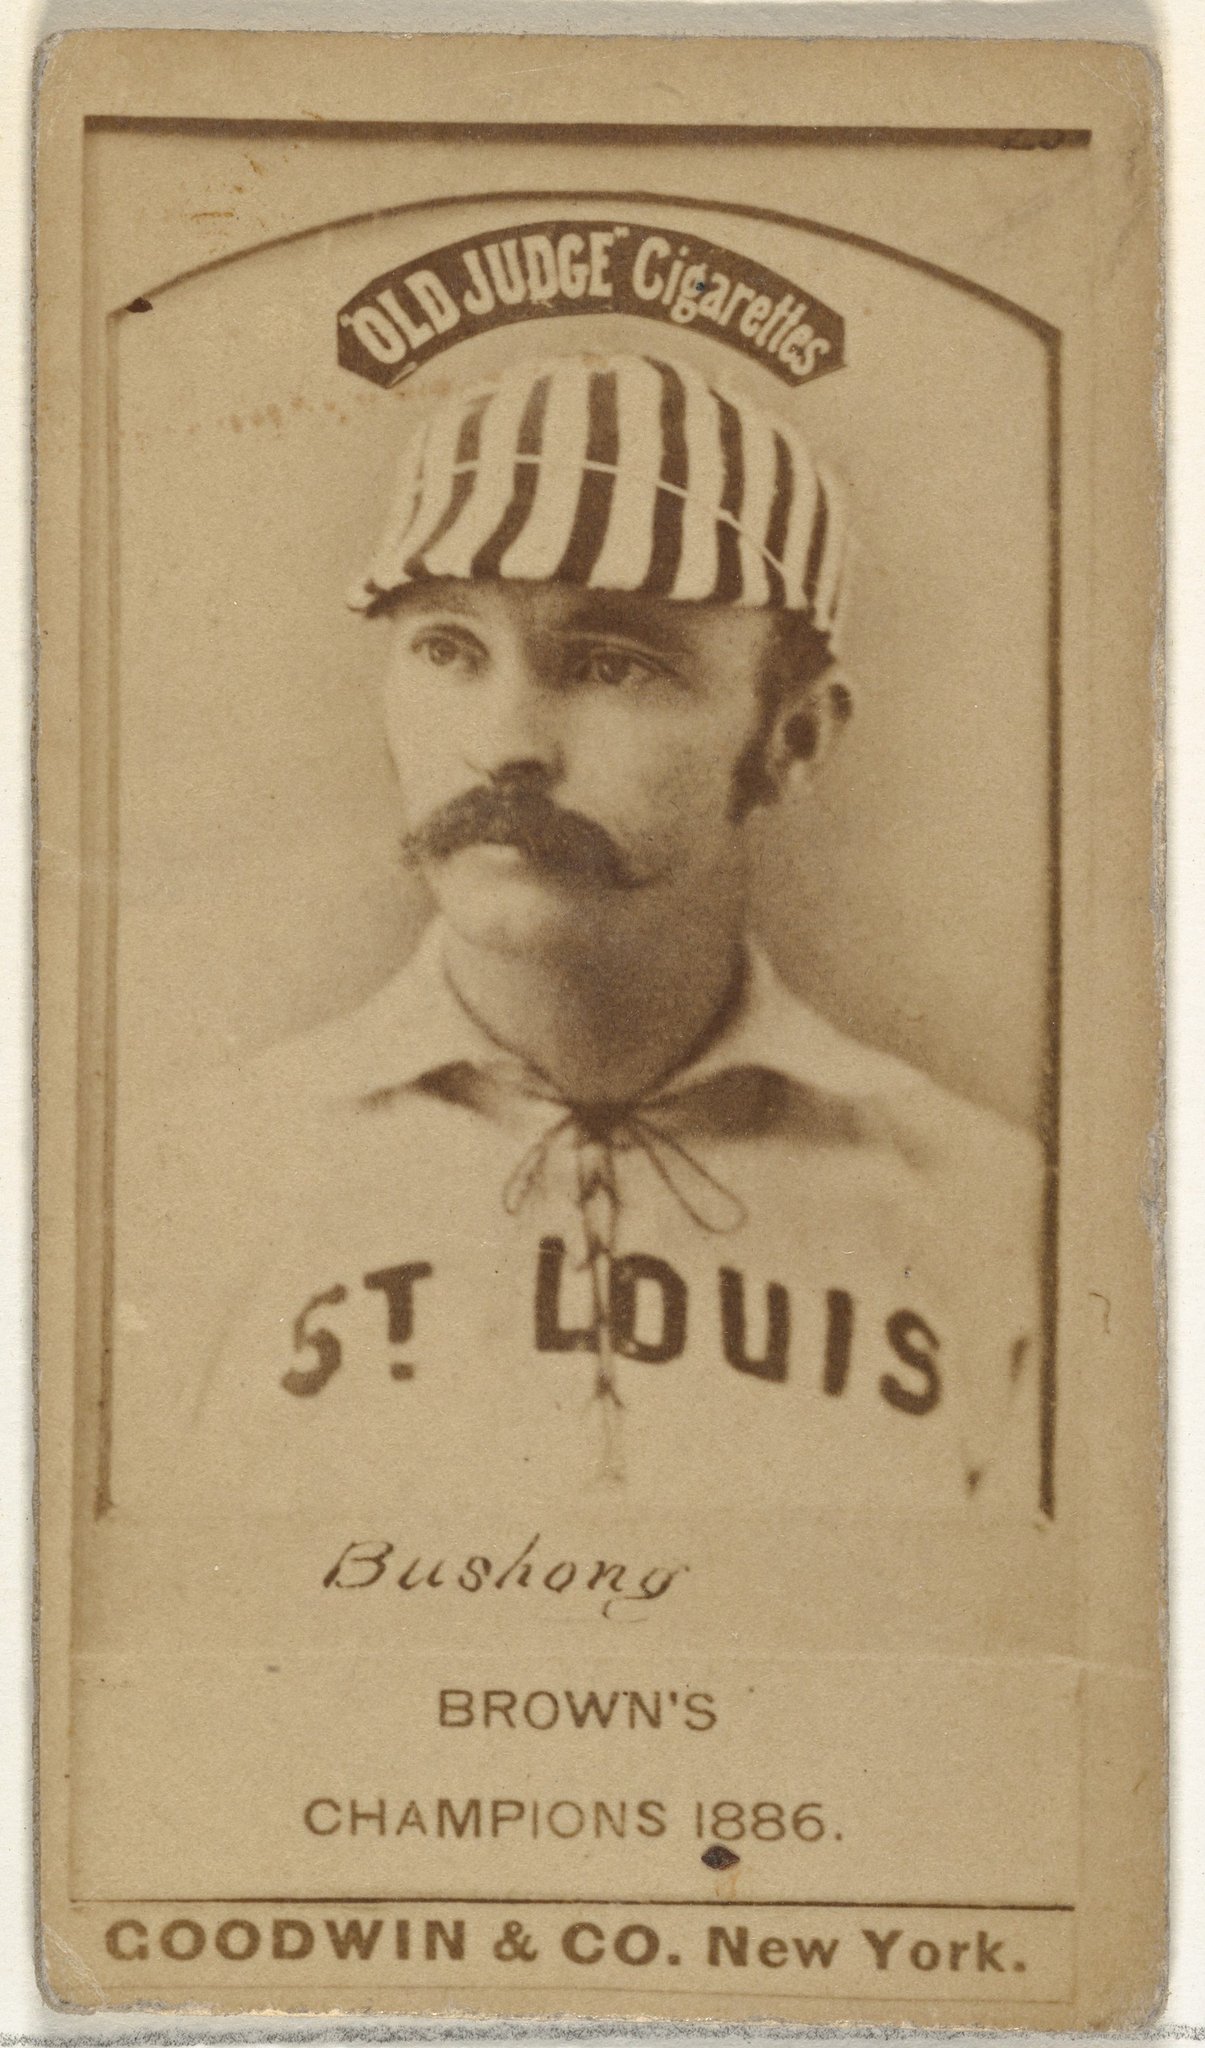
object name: baseball card, photograph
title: Albert John "Doc" Bushong, Catcher, St. Louis Browns, from the Old Judge series (N172) for Old Judge Cigarettes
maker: goodwin & company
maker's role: publisher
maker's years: 1850-1950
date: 1886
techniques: albumen silver print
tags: men,portraits,baseball,athletes